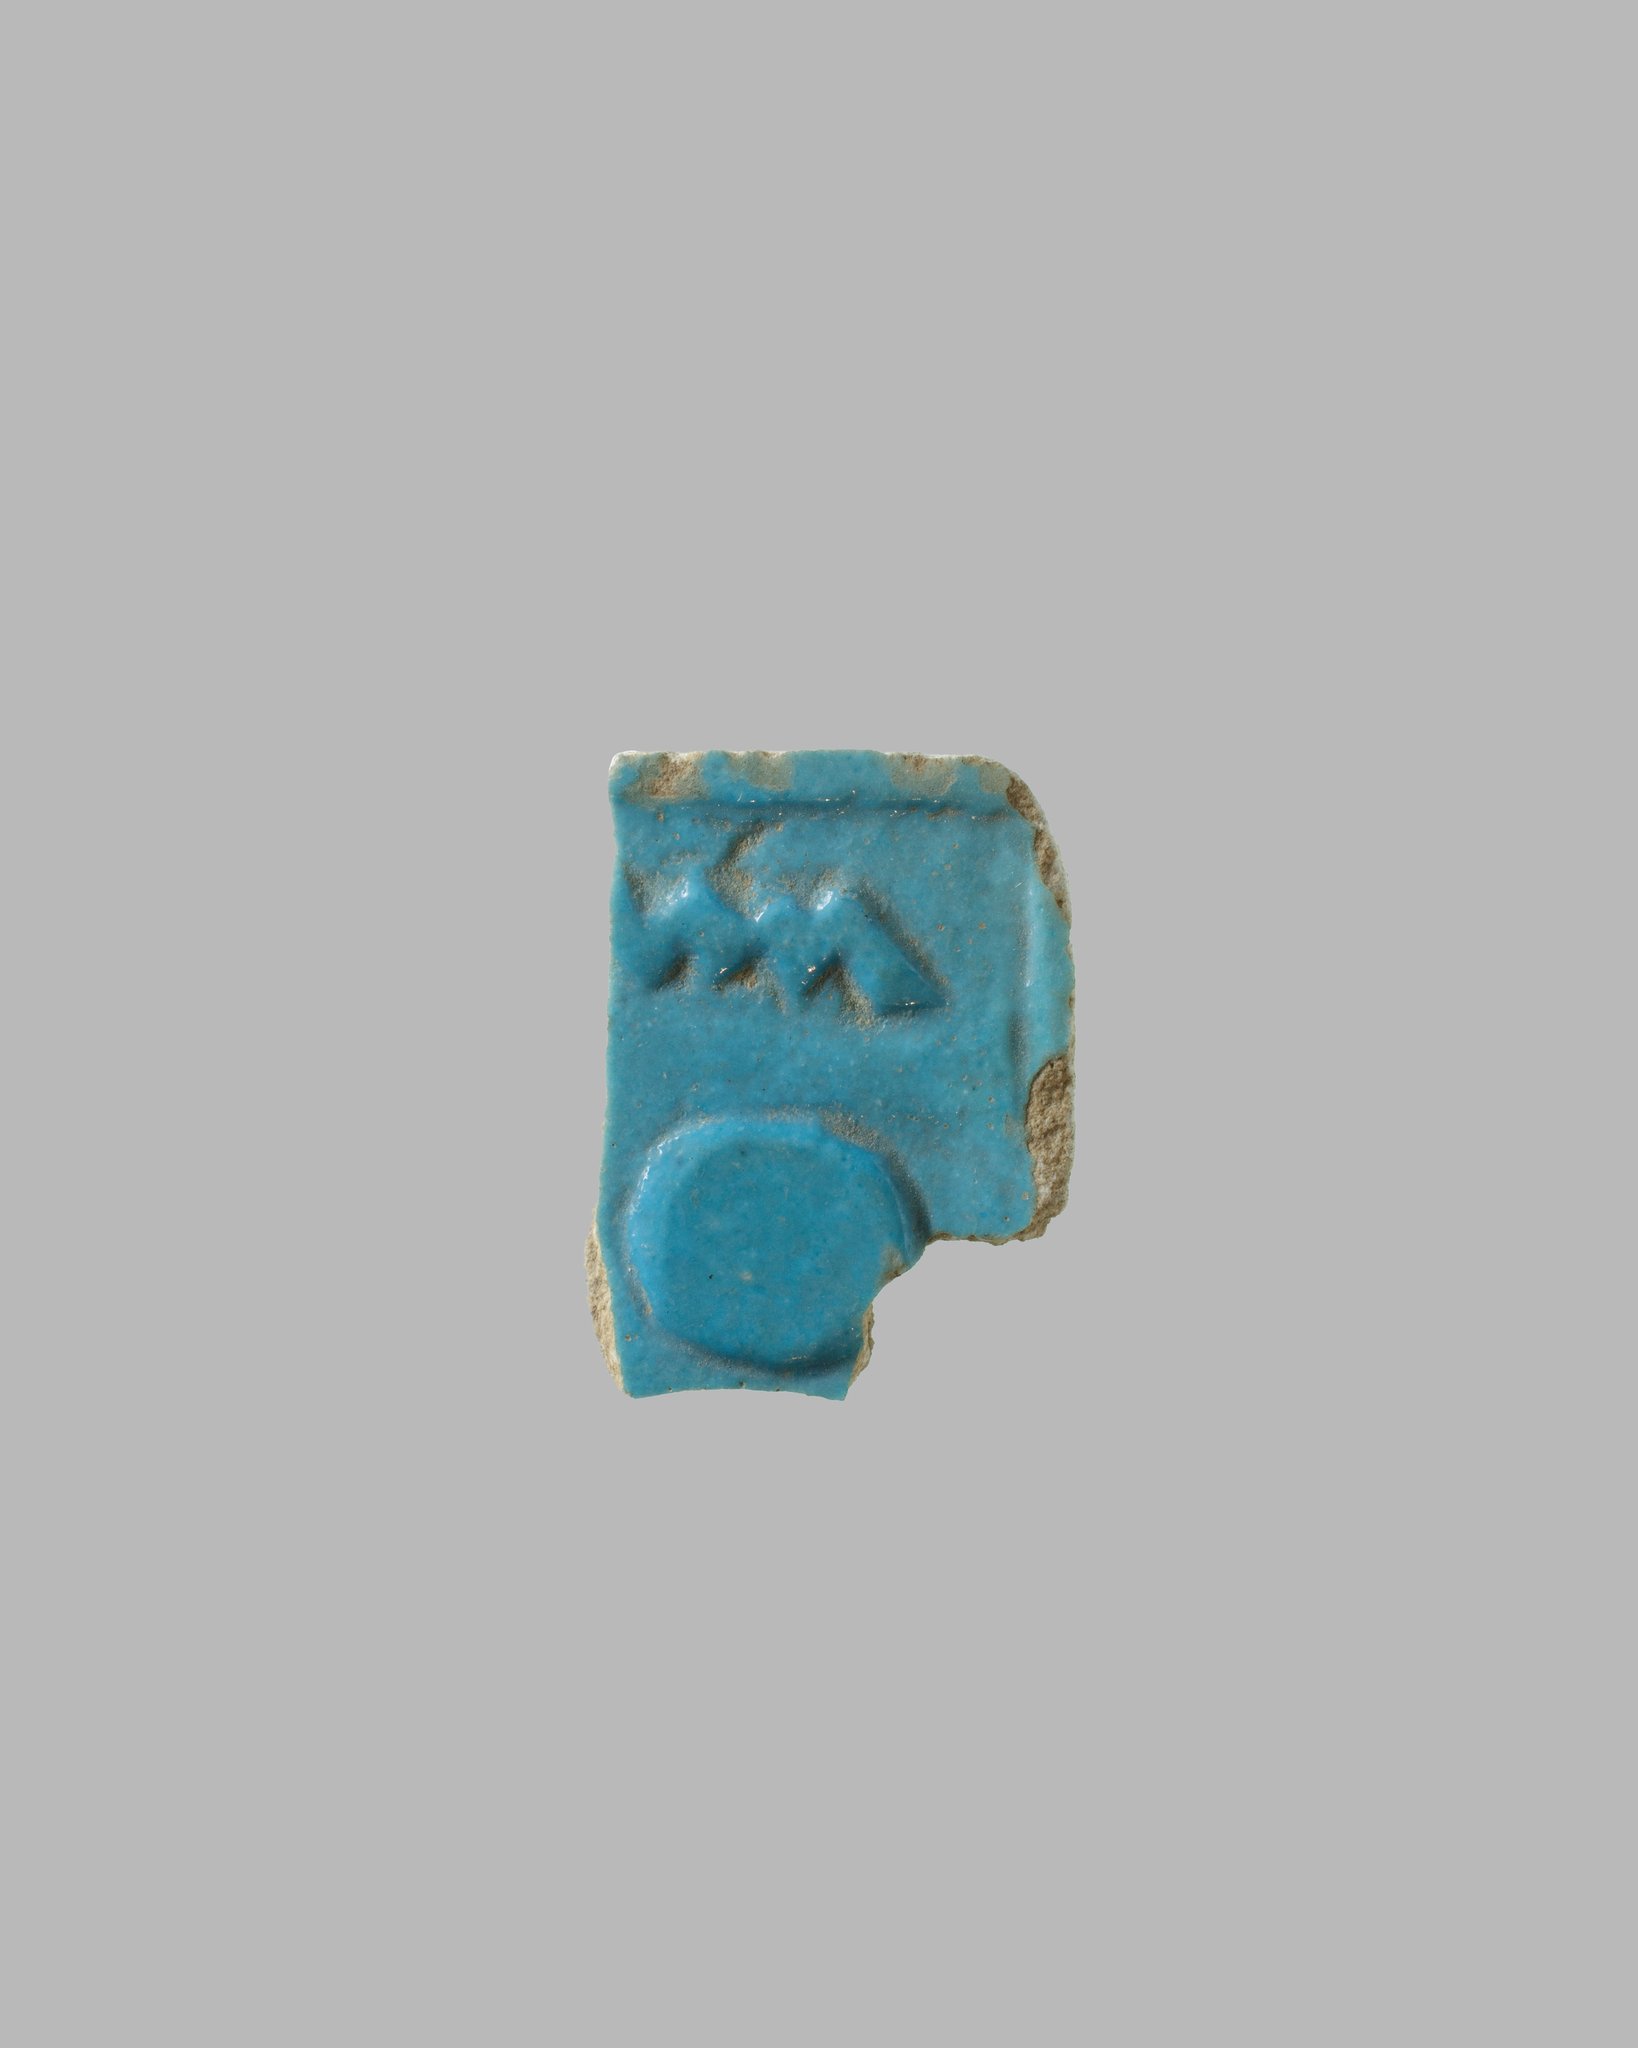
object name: inlay fragment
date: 1981-1640 BCE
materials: faience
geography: egypt